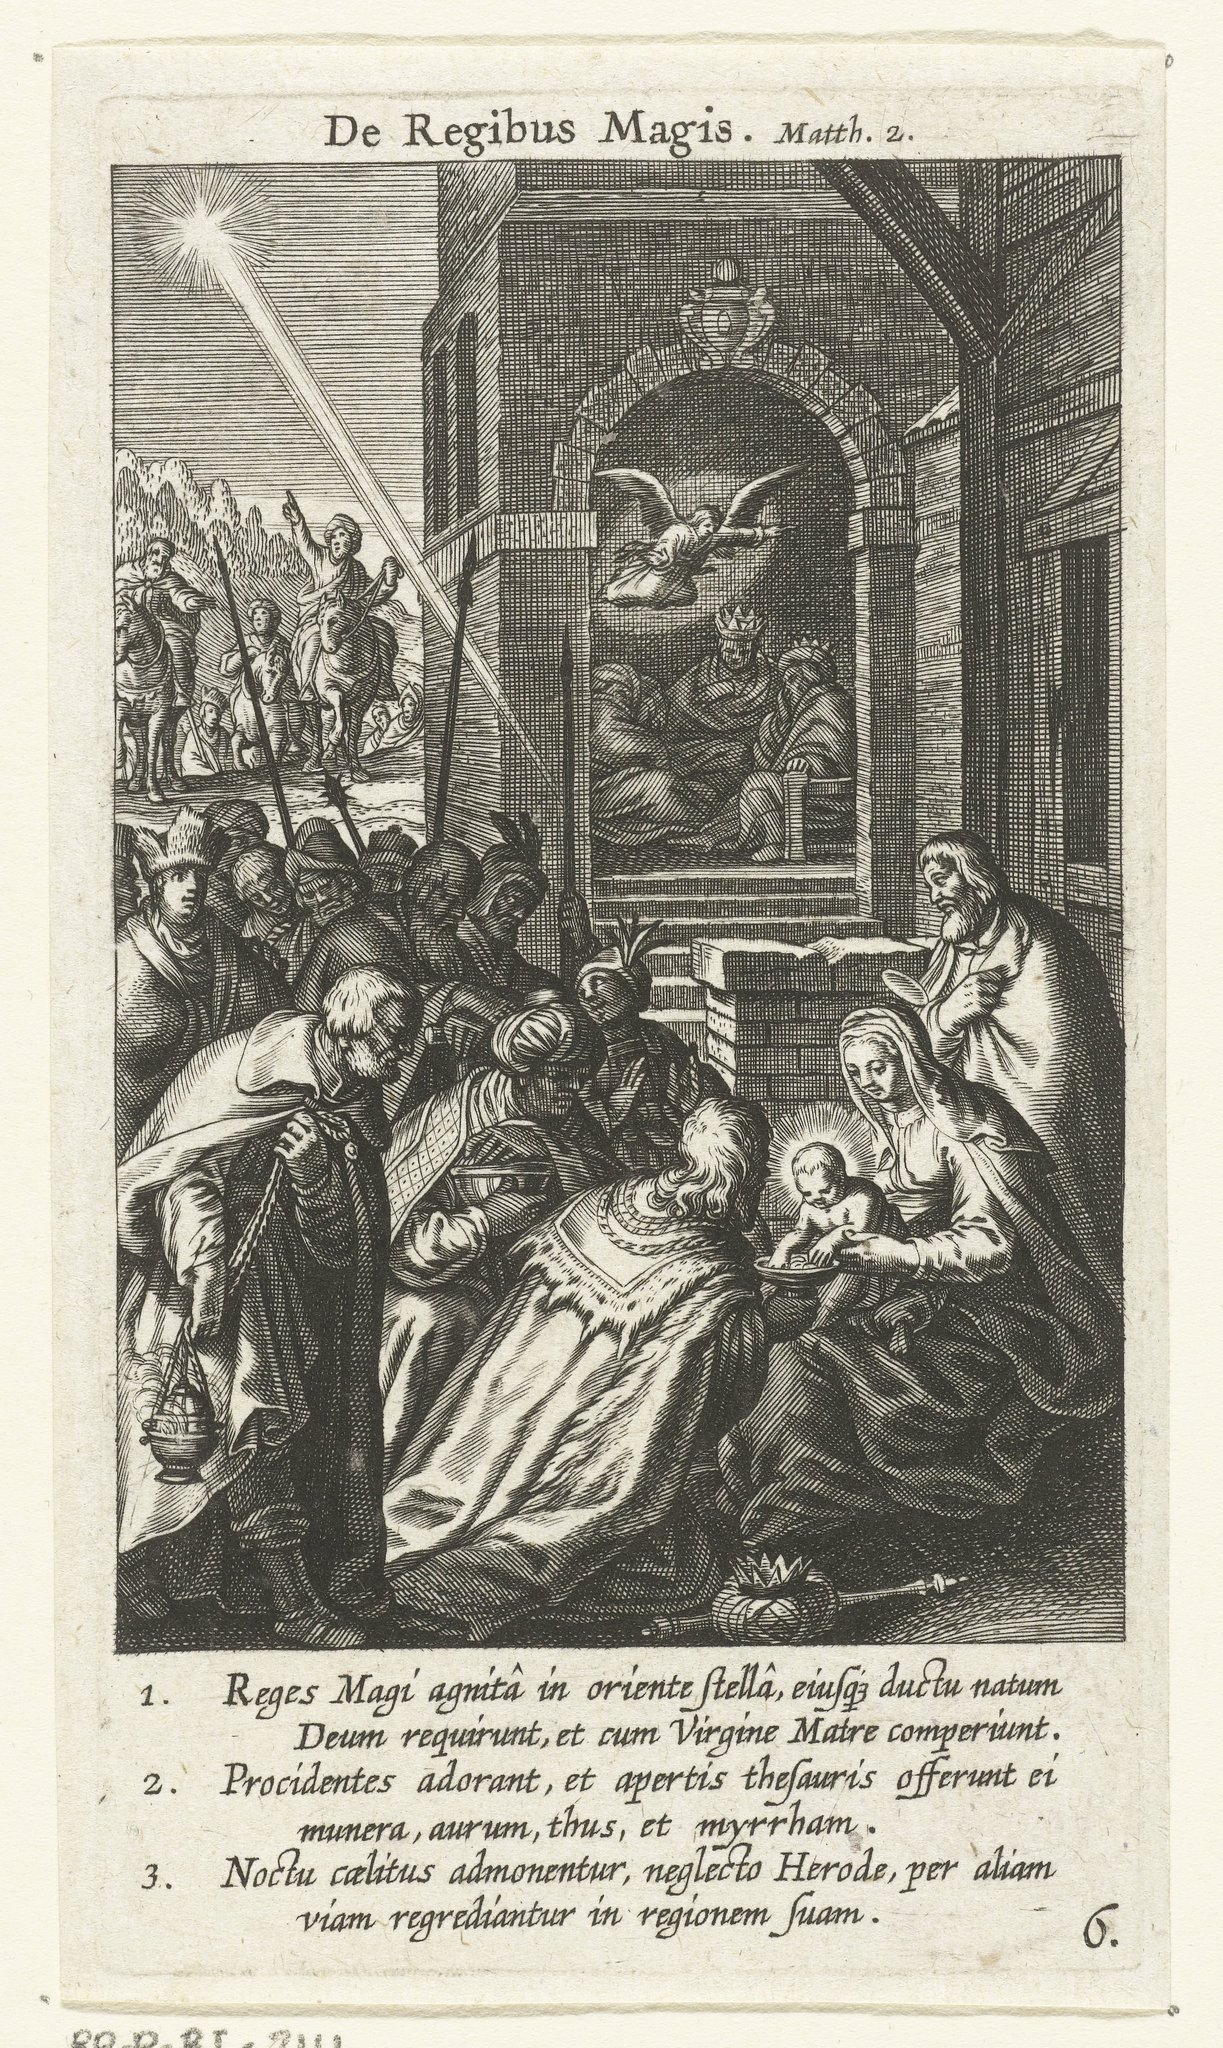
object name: book illustration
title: Aanbidding der koningen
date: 1590-1622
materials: paper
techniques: engraving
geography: antwerp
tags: adoration of the kings: the wise men present their gifts to the christ-child (gold, frankincense and myrrh), the three wise men are warned in a dream by an angel not to return to herod, the three wise men see a star and are astonished by its magnitude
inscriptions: collector's mark: Lugt 240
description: Drie koningen aanbidden het Christuskind. Twee scènes in het landschap tonen twee andere gebeurtenissen uit het bijbelverhaal: de drie koningen op reis volgen de ster die hun de weg wijst naar de Koning der Joden en de engel waarschuwt de drie koningen om niet terug te keren naar Herodes.